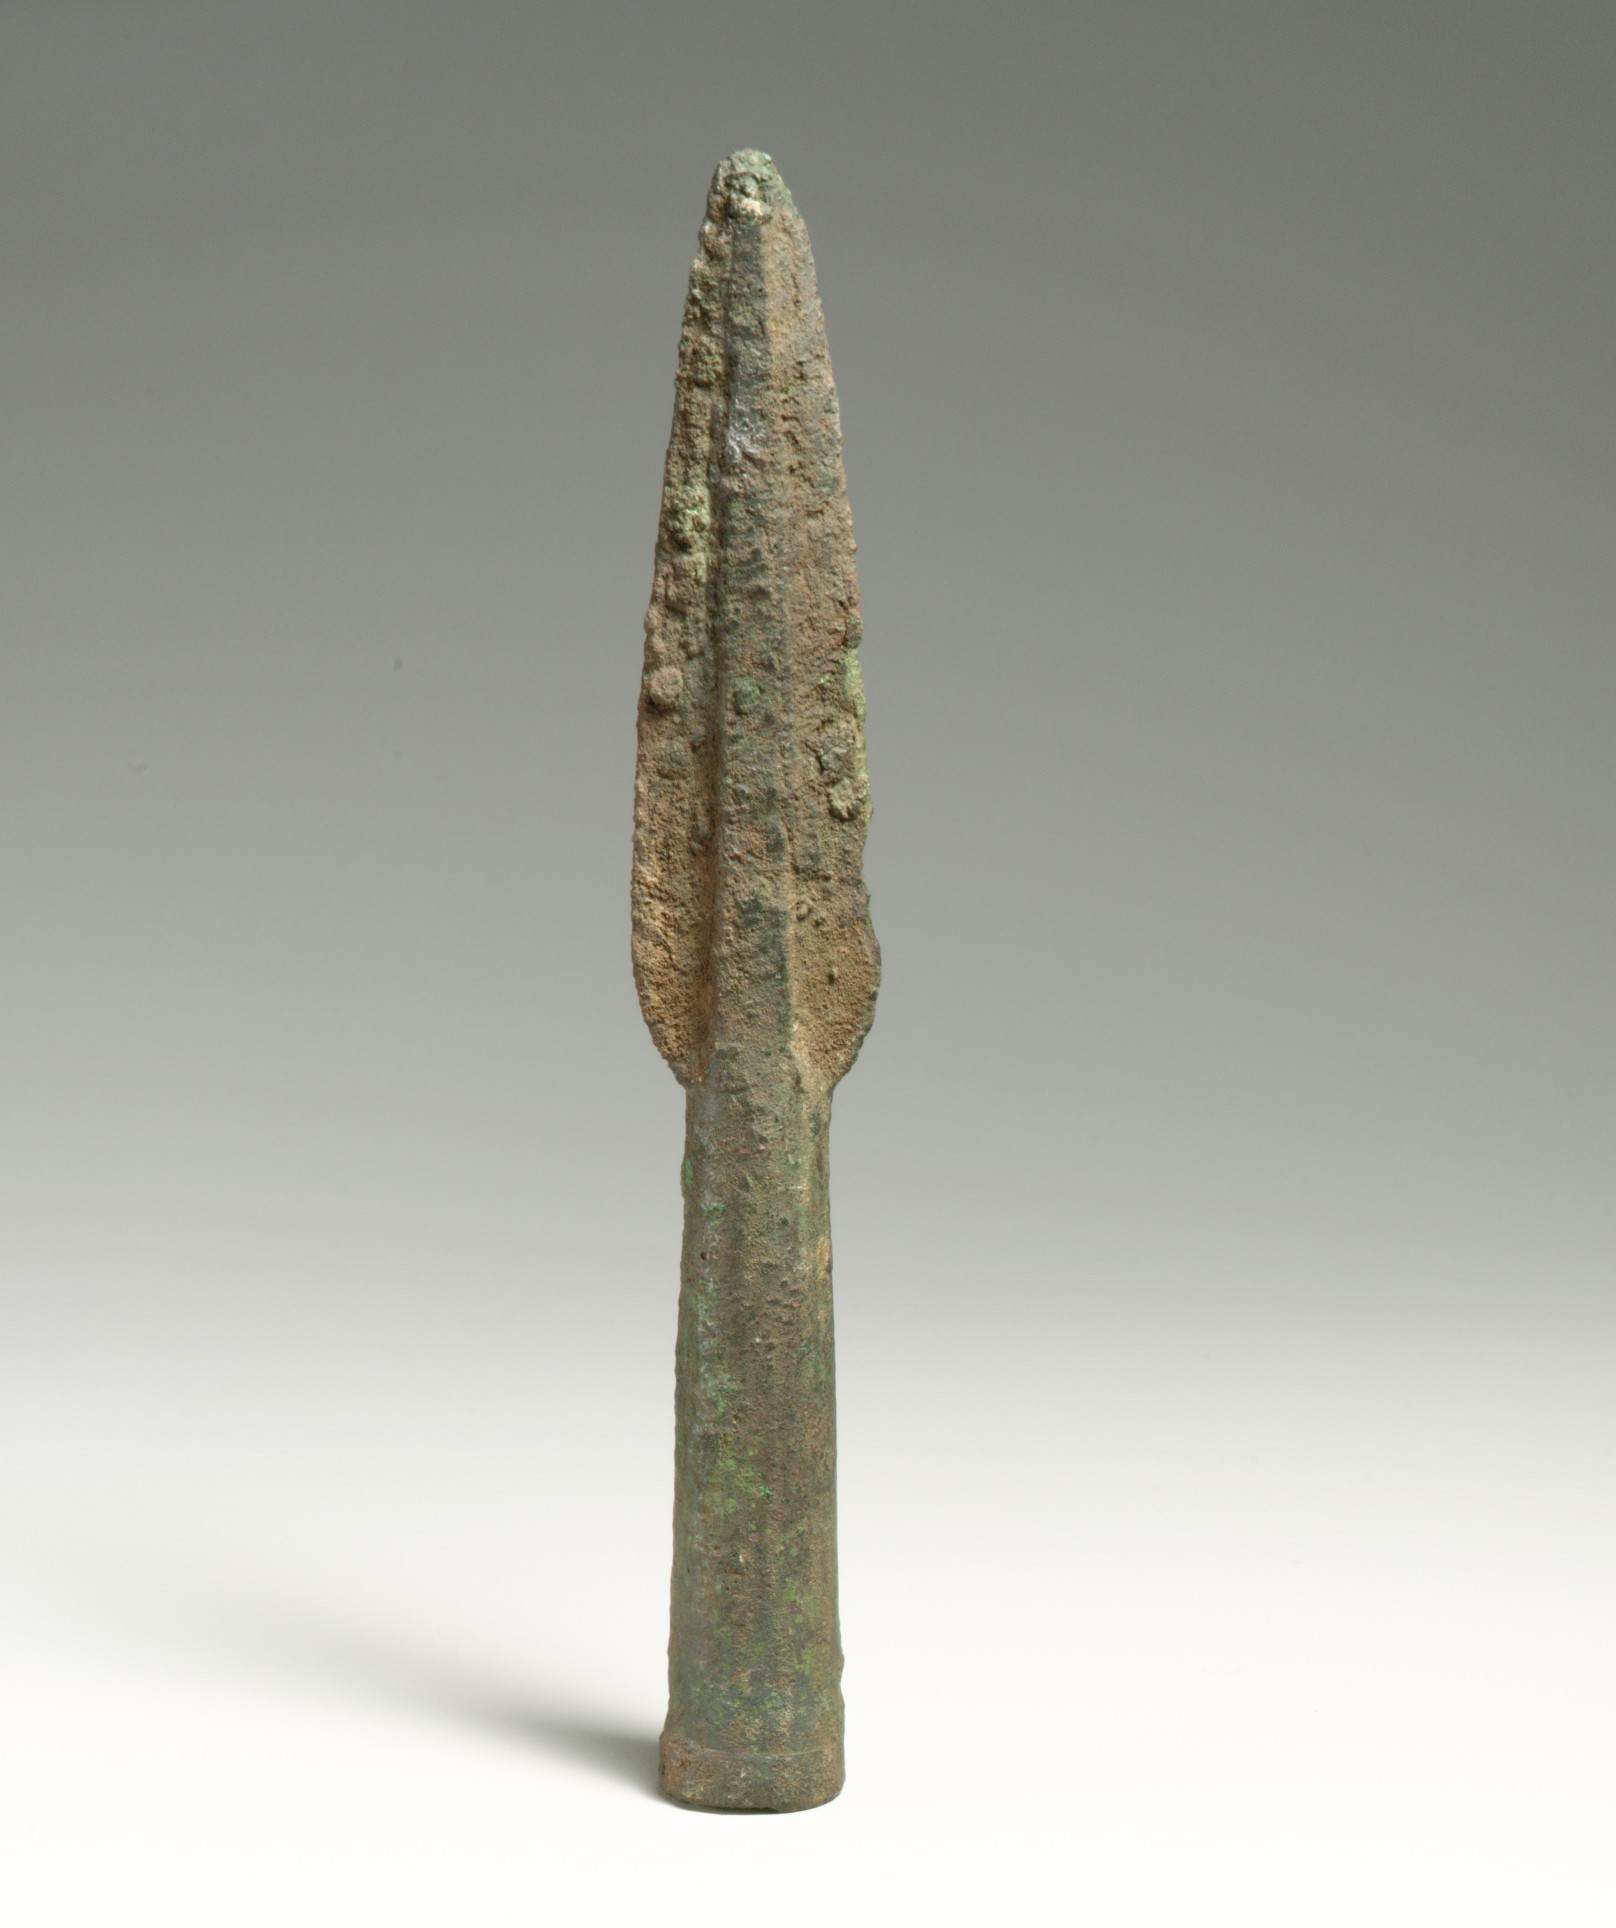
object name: spearhead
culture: cypriot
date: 1600-1050 BCE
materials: bronze